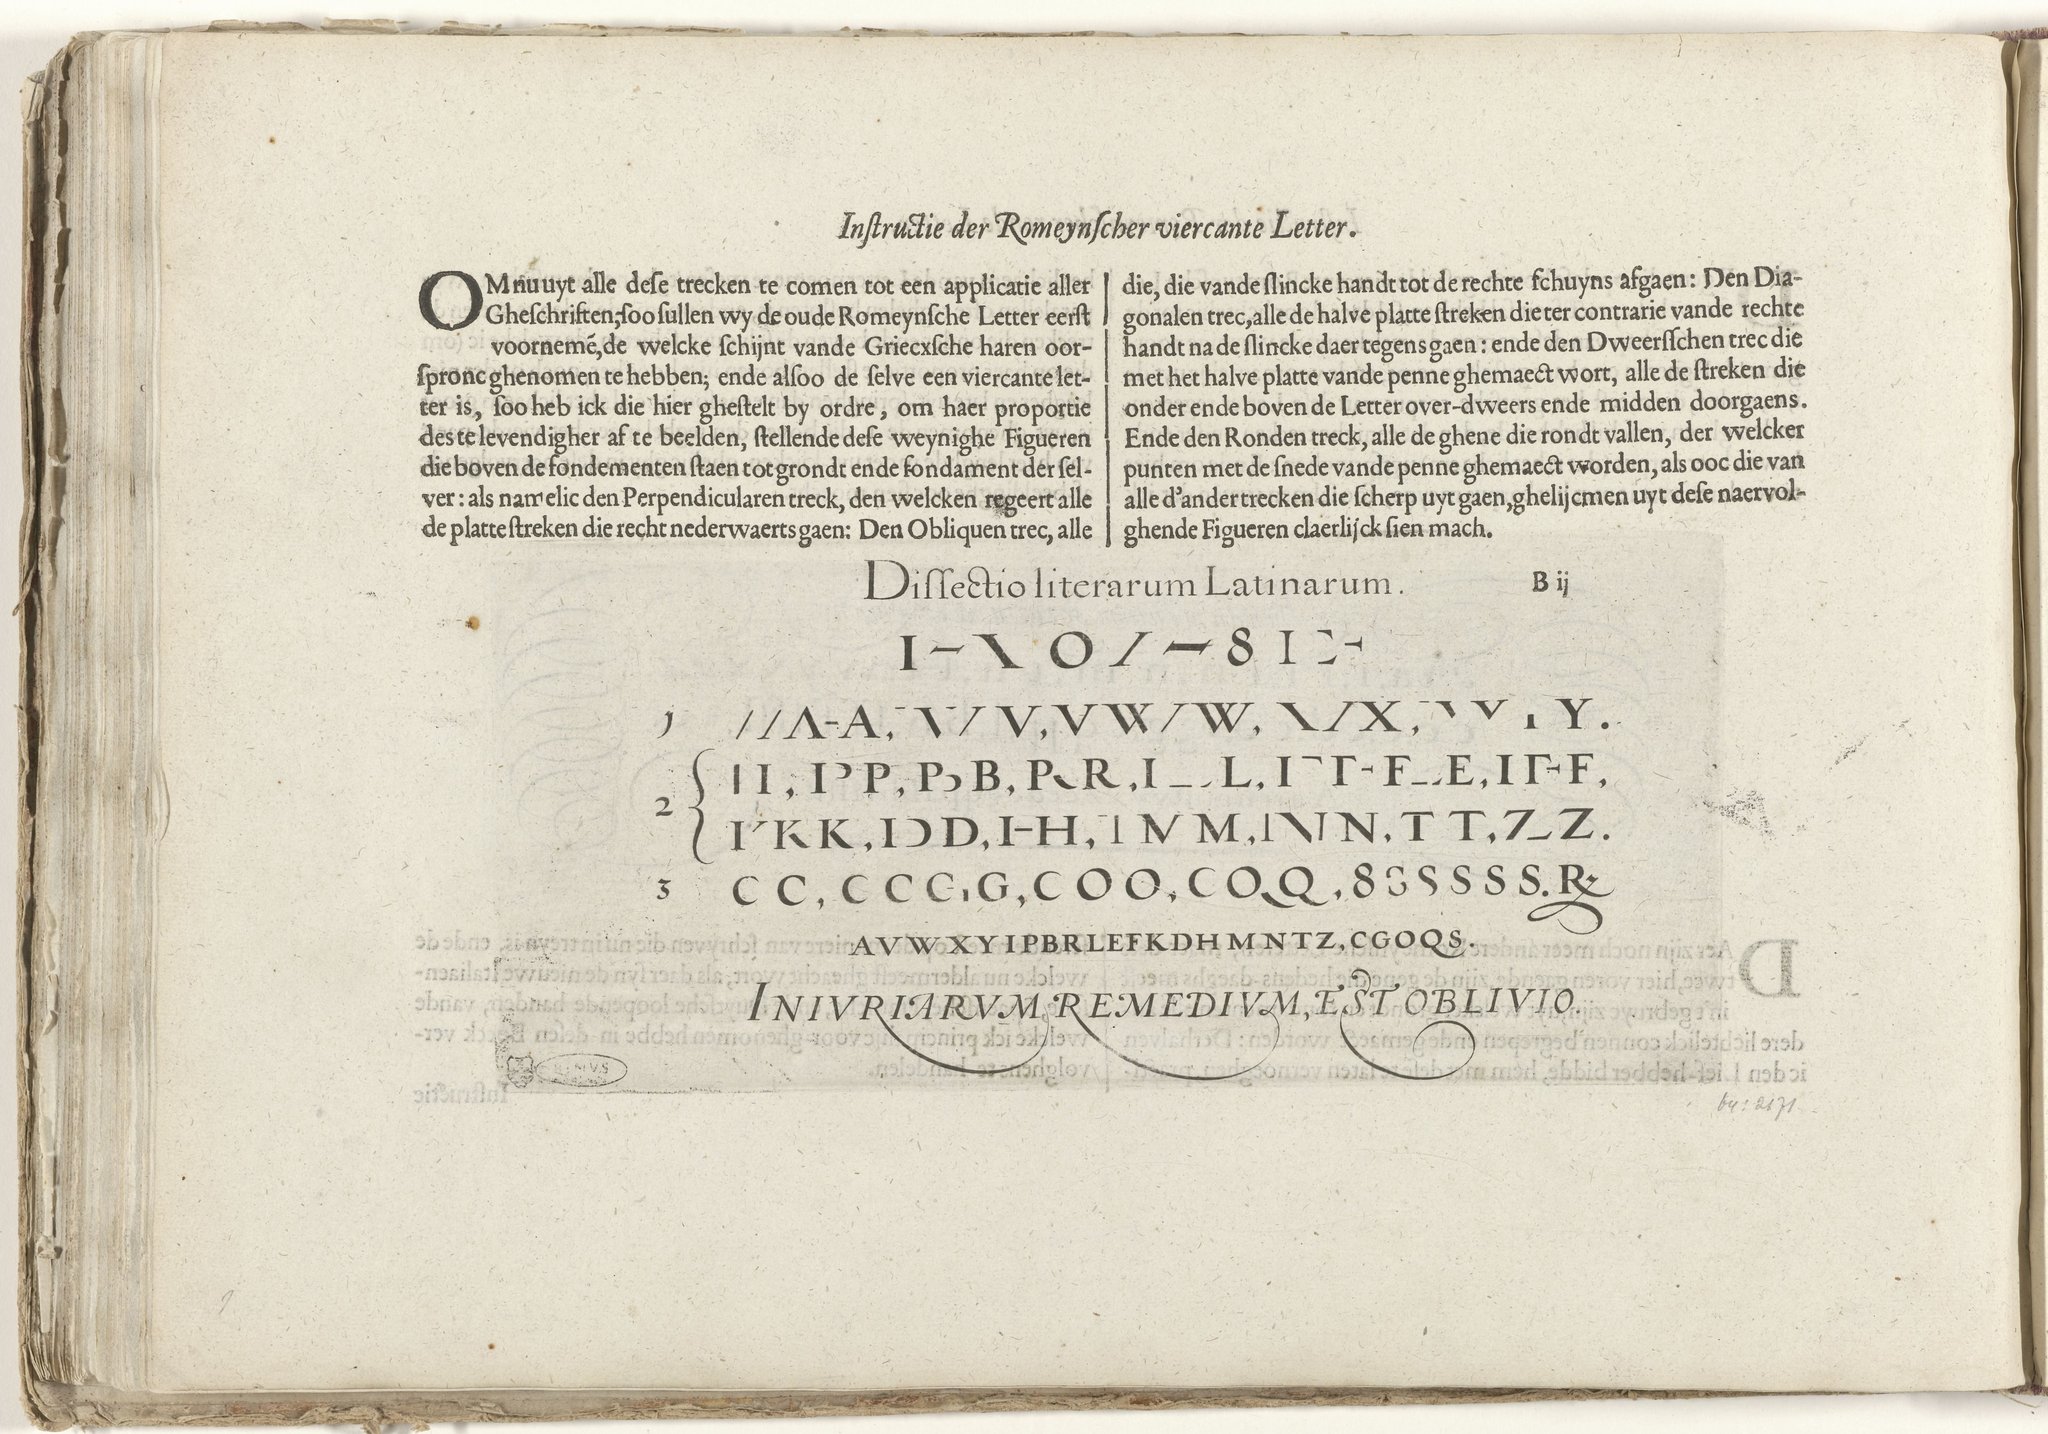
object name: print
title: Beschrijving en schrijfvoorbeeld van de Romeinse vierkante letter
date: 1605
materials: paper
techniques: engraving, letterpress printing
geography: amsterdam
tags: calligraphy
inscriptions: collector's mark: Lugt 2760, collector's mark: Lugt 2228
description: Folio B2r met een schrijfvoorbeeld getiteld: Dissectio literarum Latinarum. De beschrijving vangt aan met een kleine initiaal O. Het blad maakt deel uit van een album.